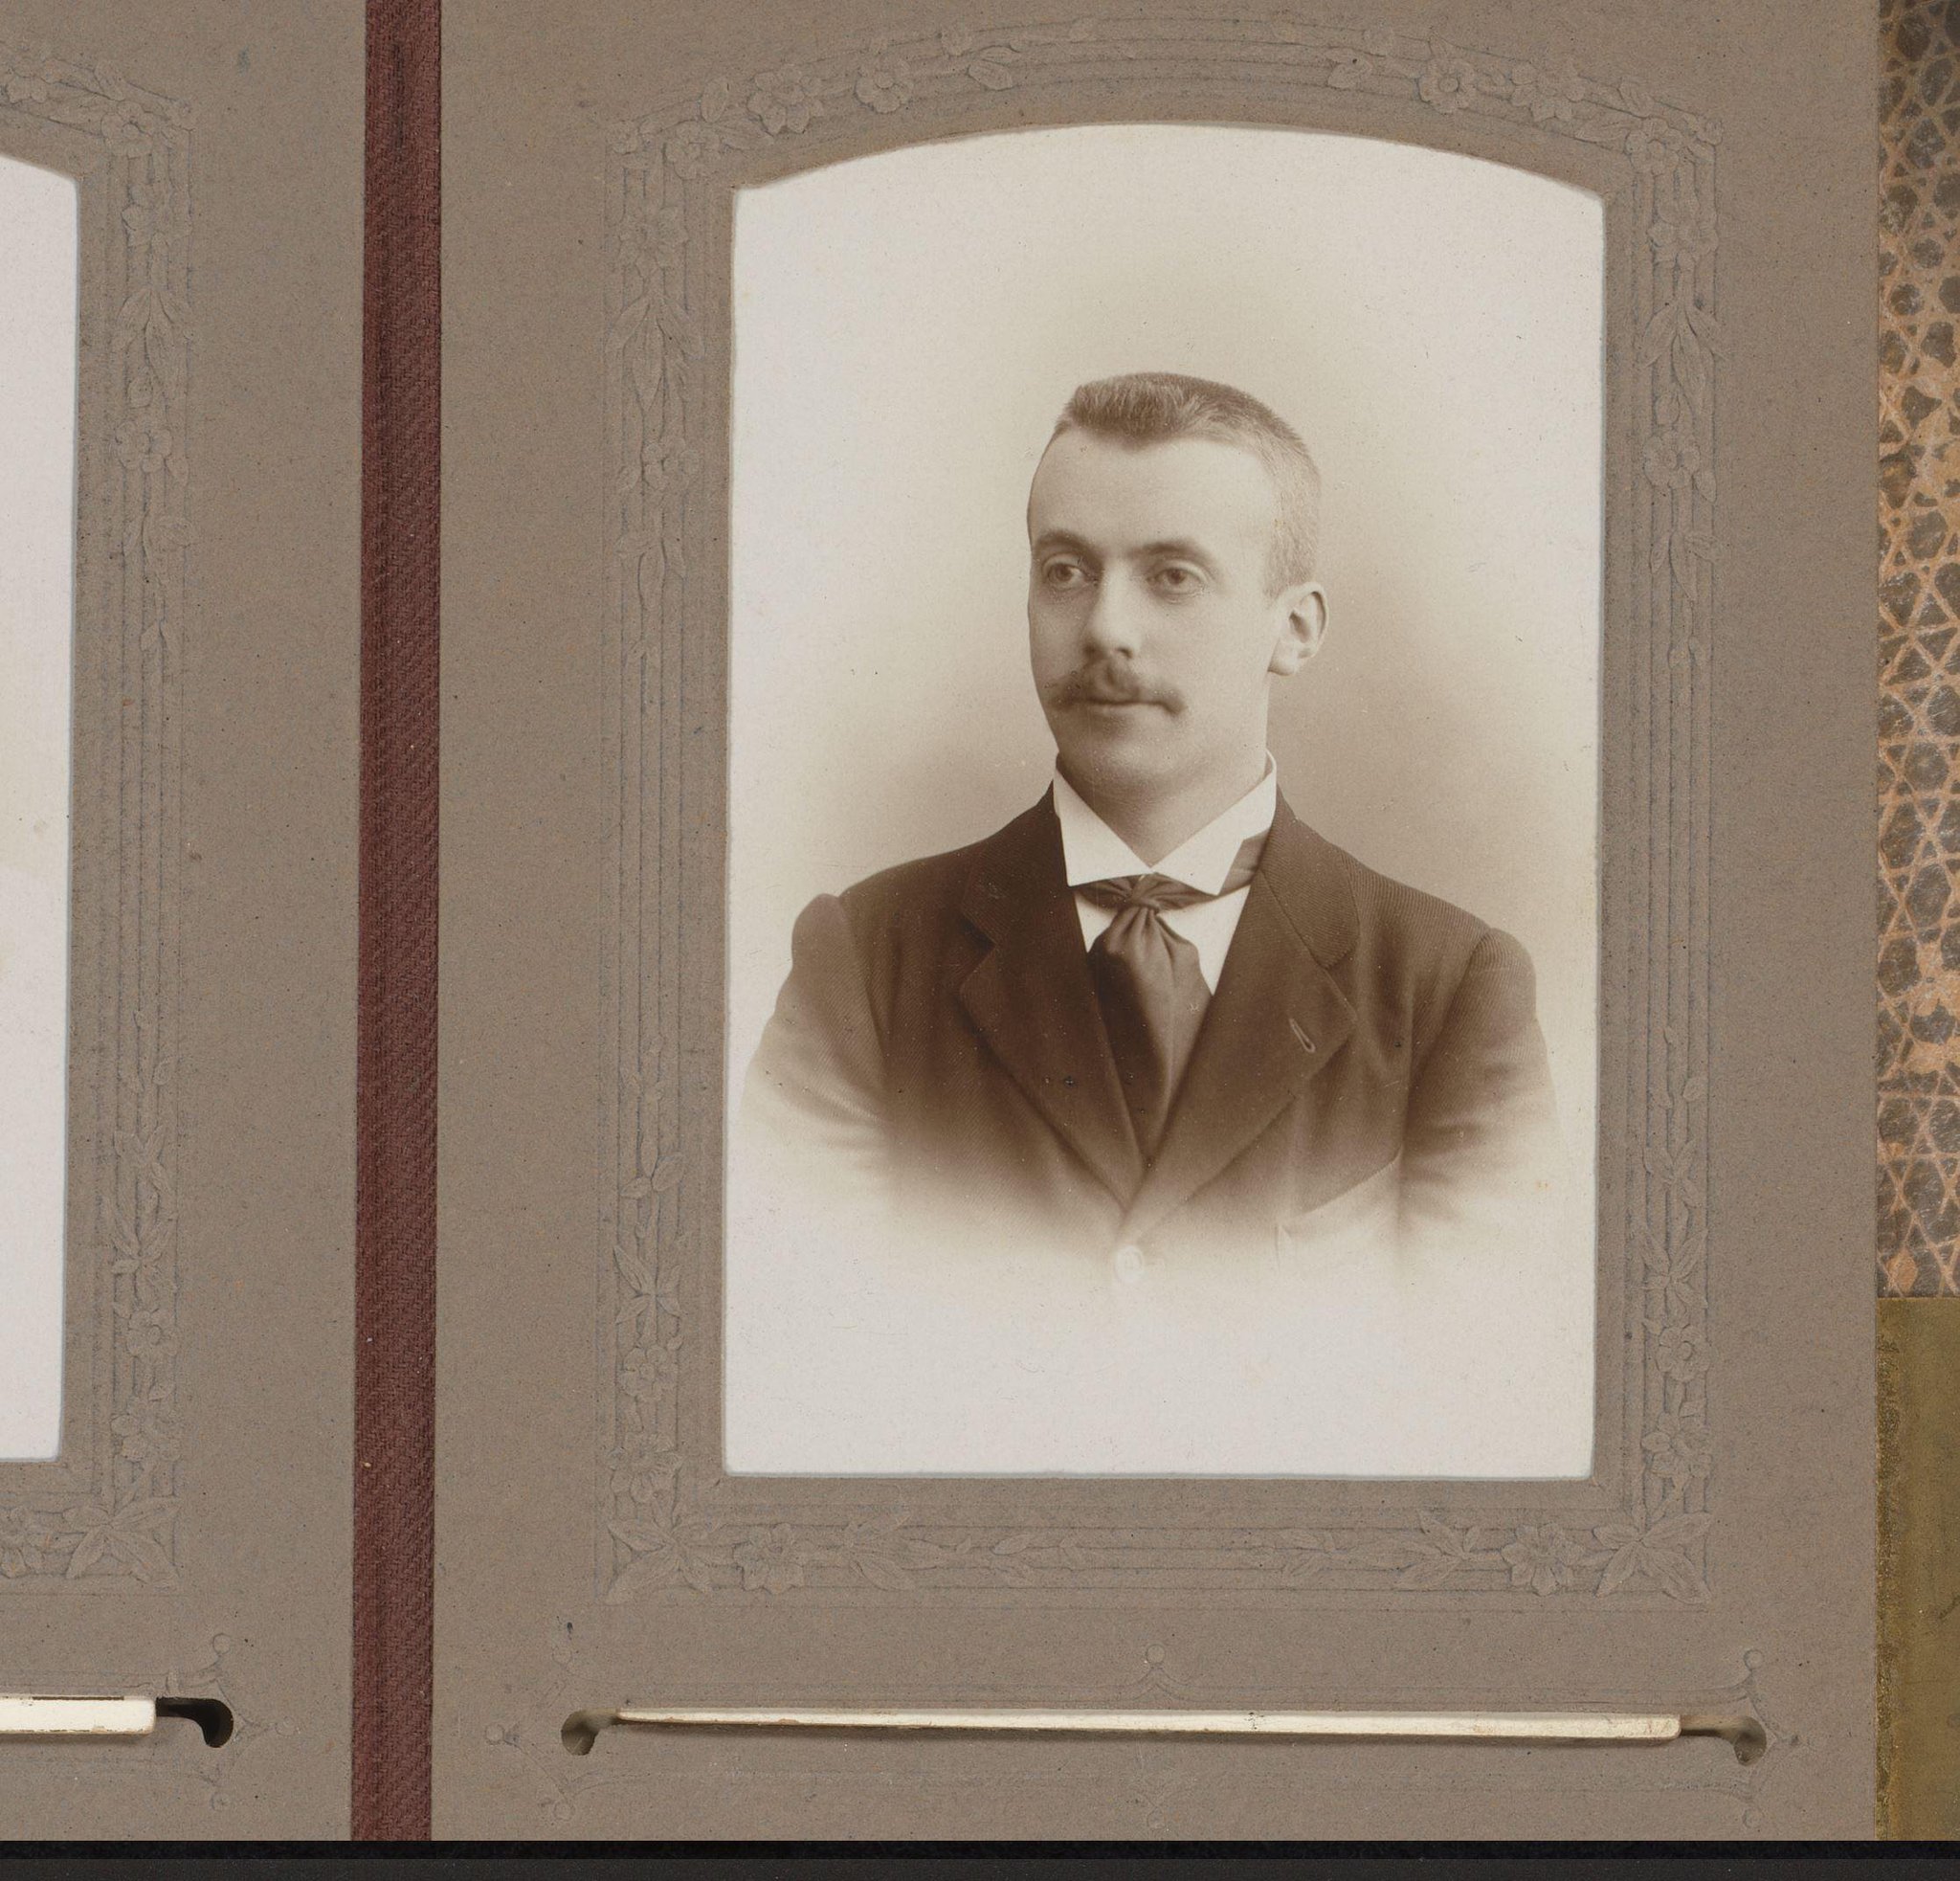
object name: carte de visite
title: Portret van een man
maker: albert greiner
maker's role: fotograaf, fotostudio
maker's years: 1833-1890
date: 1874-1887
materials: cardboard, photographic support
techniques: collodion silver print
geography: amsterdam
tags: historical persons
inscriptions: inscription: ‘ALBERT GREINER/ Photograaf van wijlen Z. M. den/ Koning Willem III en van H. M. de Koningin Weduwe./ AMSTERDAM/ NIEUWENDIJK 89./ Specialiteit in Vergrootingen.’